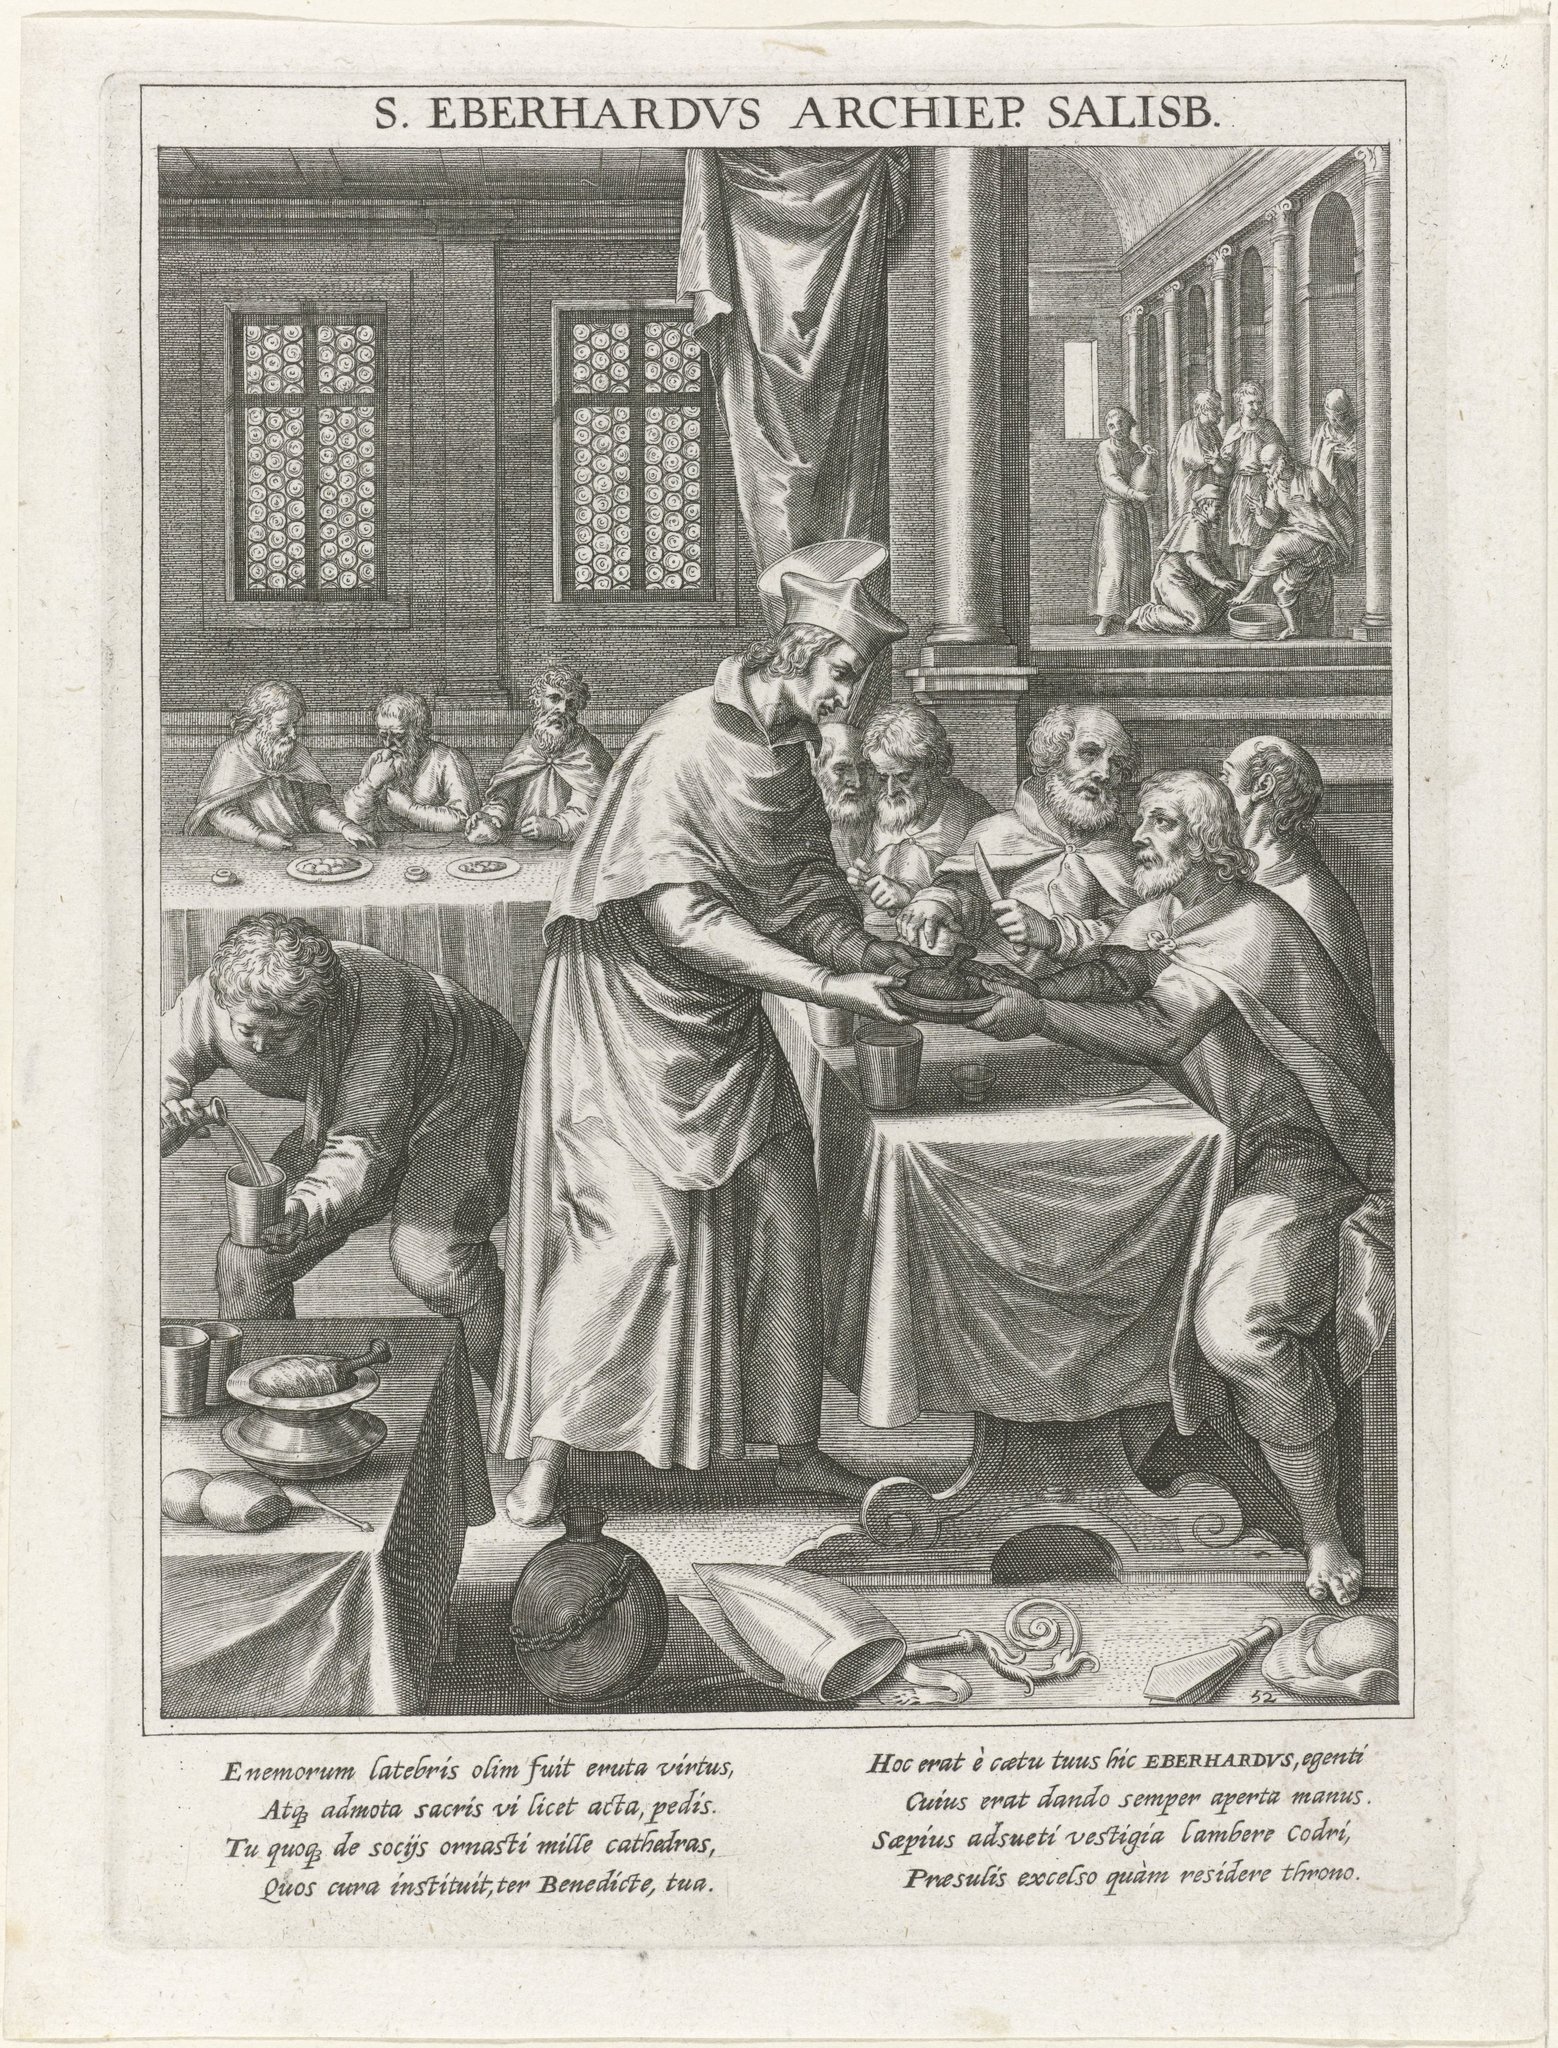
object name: print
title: Liefdadigheid van de Heilige Everardus van Salzburg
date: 1615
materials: paper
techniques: engraving, etching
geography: munich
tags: male saints (with name), feeding the hungry, 'esuriens cibatur' ~ one of the (seven) acts of mercy, charitable works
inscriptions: collector's mark: Lugt 240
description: De H. Everardus, aartsbisschop van Salzburg, deelt voedsel uit aan de noodlijdenden. Op de achtergrond wast hij de voeten van de armen. De prent heeft een Latijns onderschrift en is de 52ste prent van een 60-delige serie met als onderwerp de heiligen van Beieren.